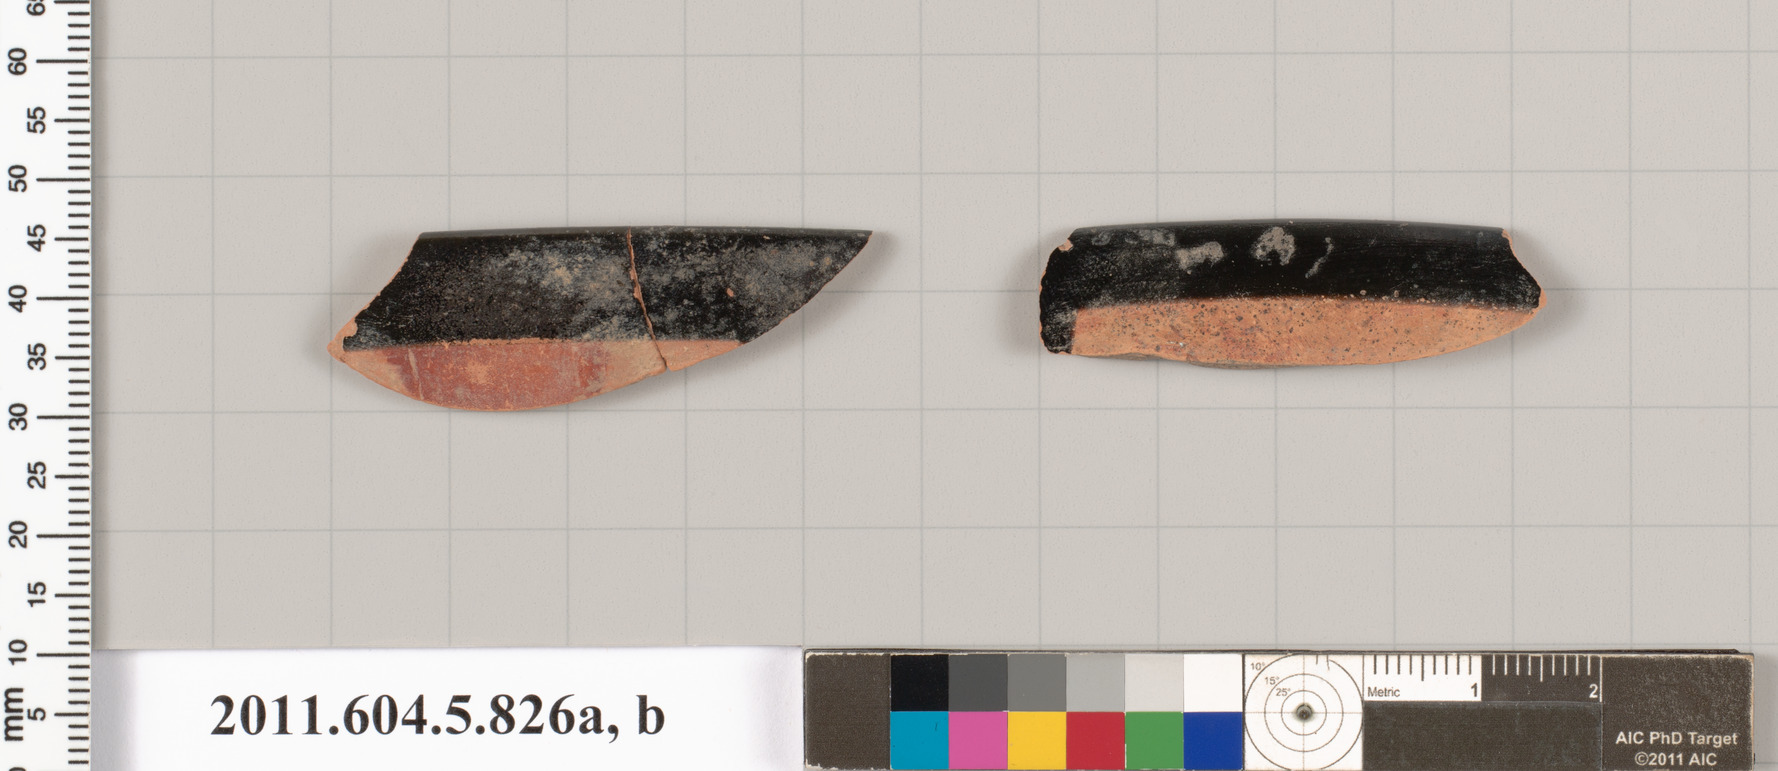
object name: kylix fragment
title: Terracotta rim fragments of kylikes (drinking cups)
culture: greek, attic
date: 600-401 BCE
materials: terracotta